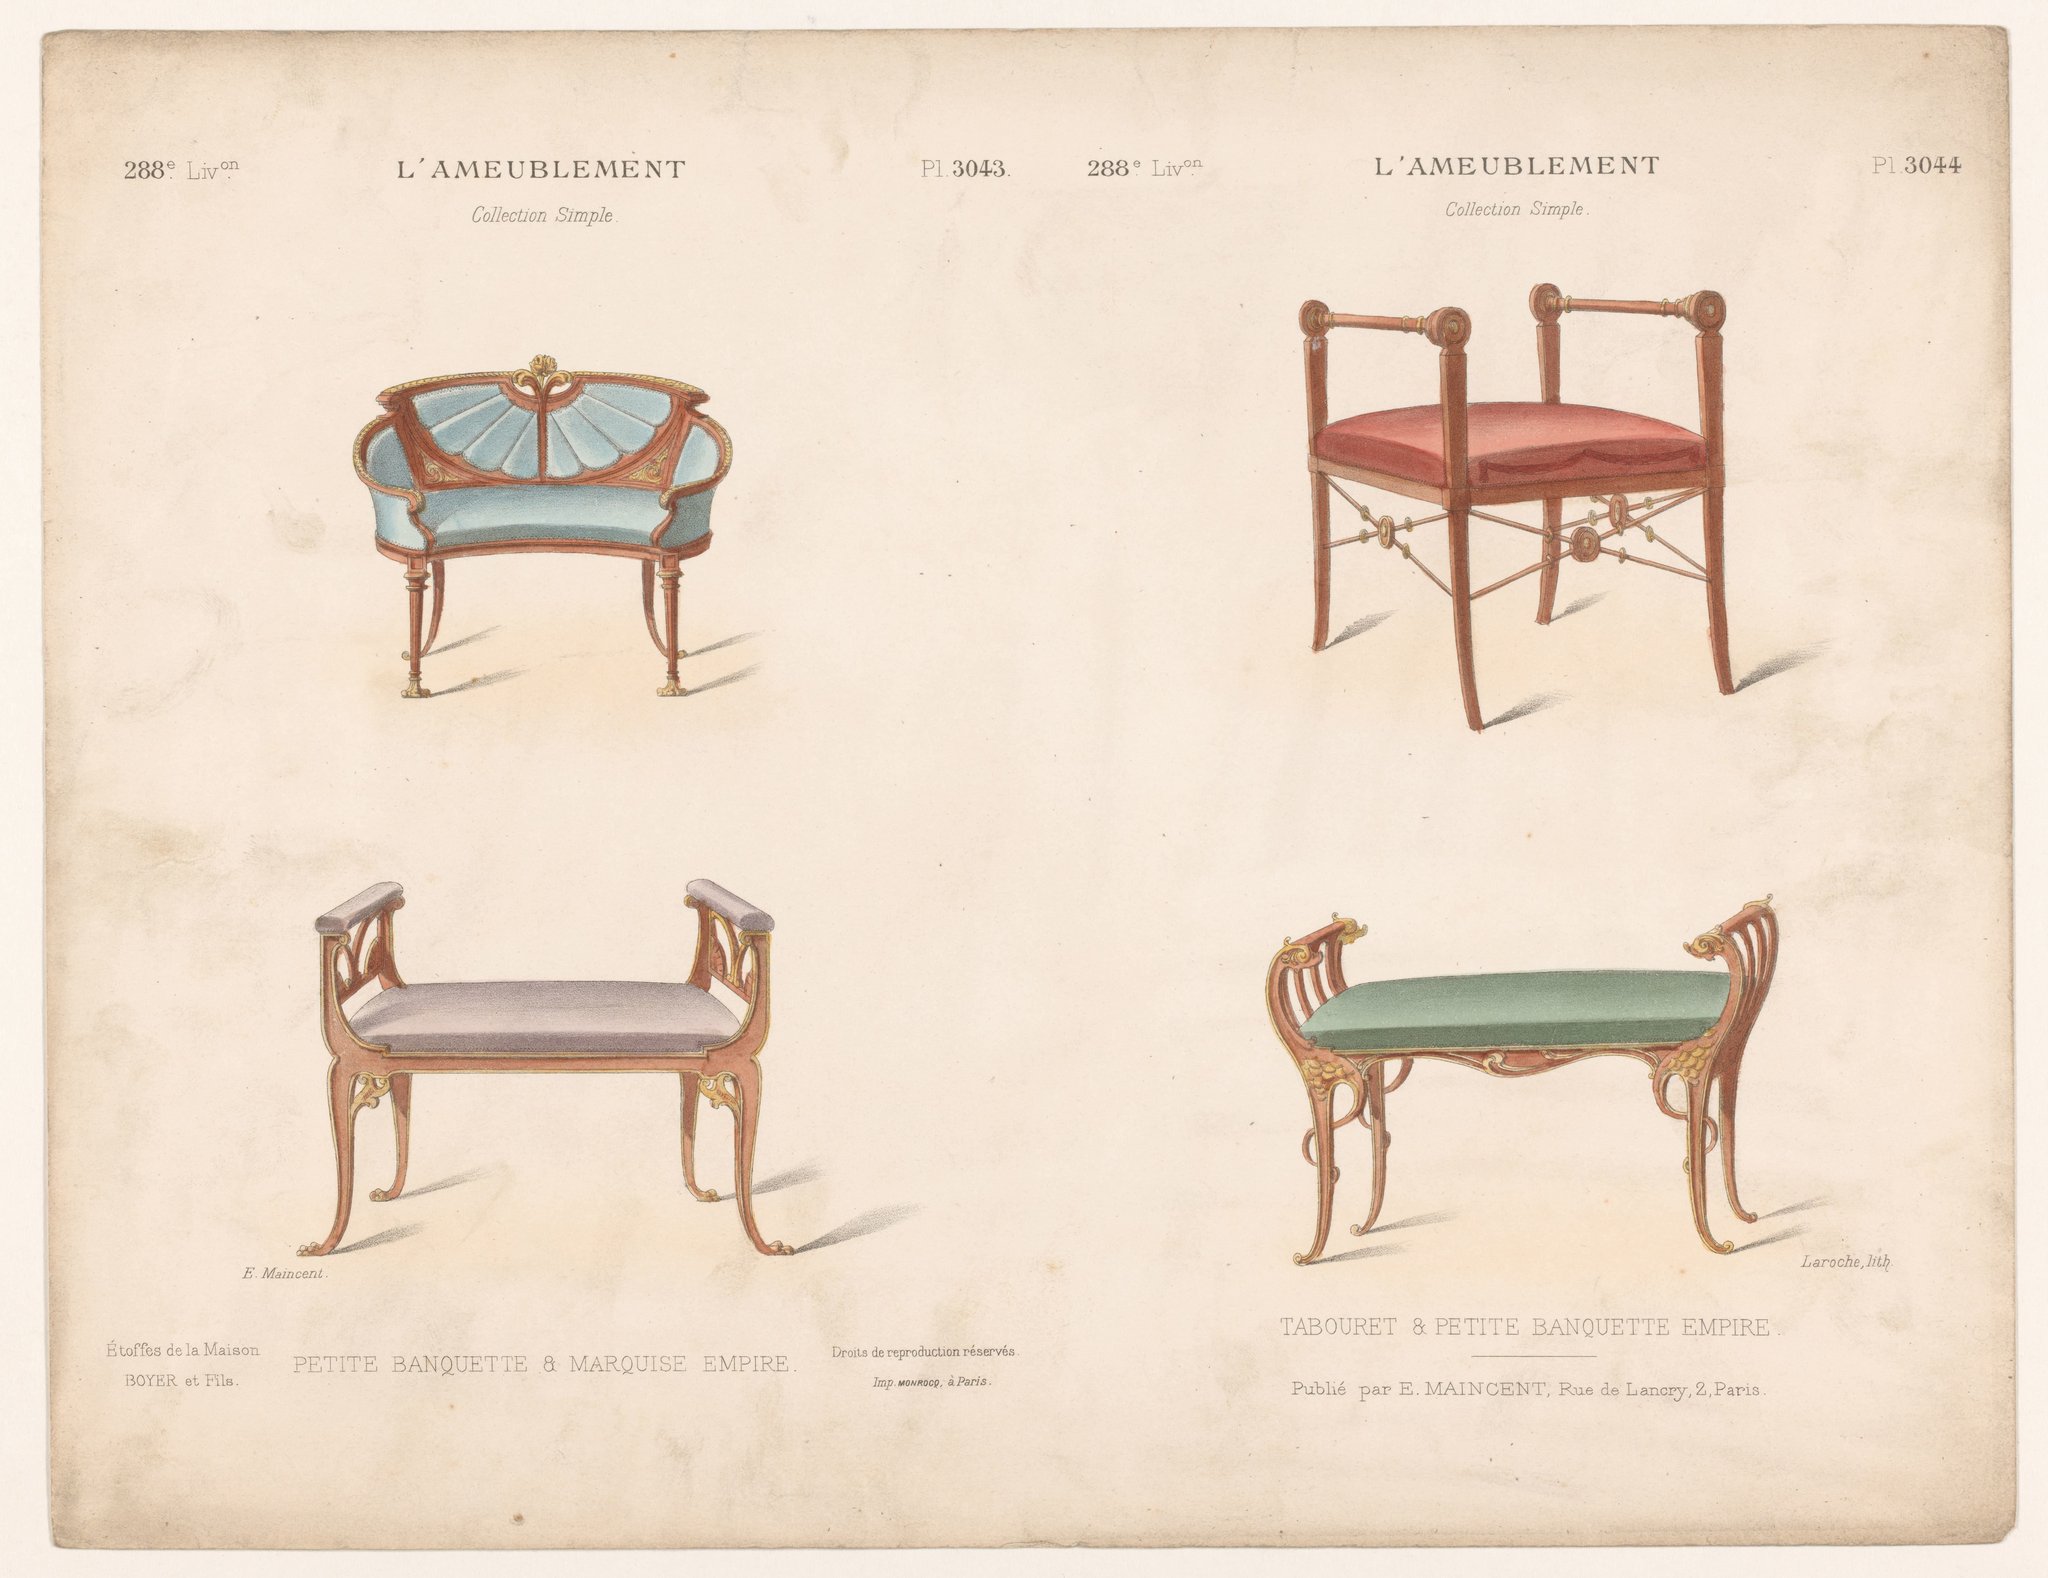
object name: print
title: L'ameublement / Collection simple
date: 1885-1895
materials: paper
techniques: hand coloring, lithograph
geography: paris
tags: seating furniture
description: Een stoel, twee banken en een tabouret in de empirestijl. Prent uit 288e Livraison.